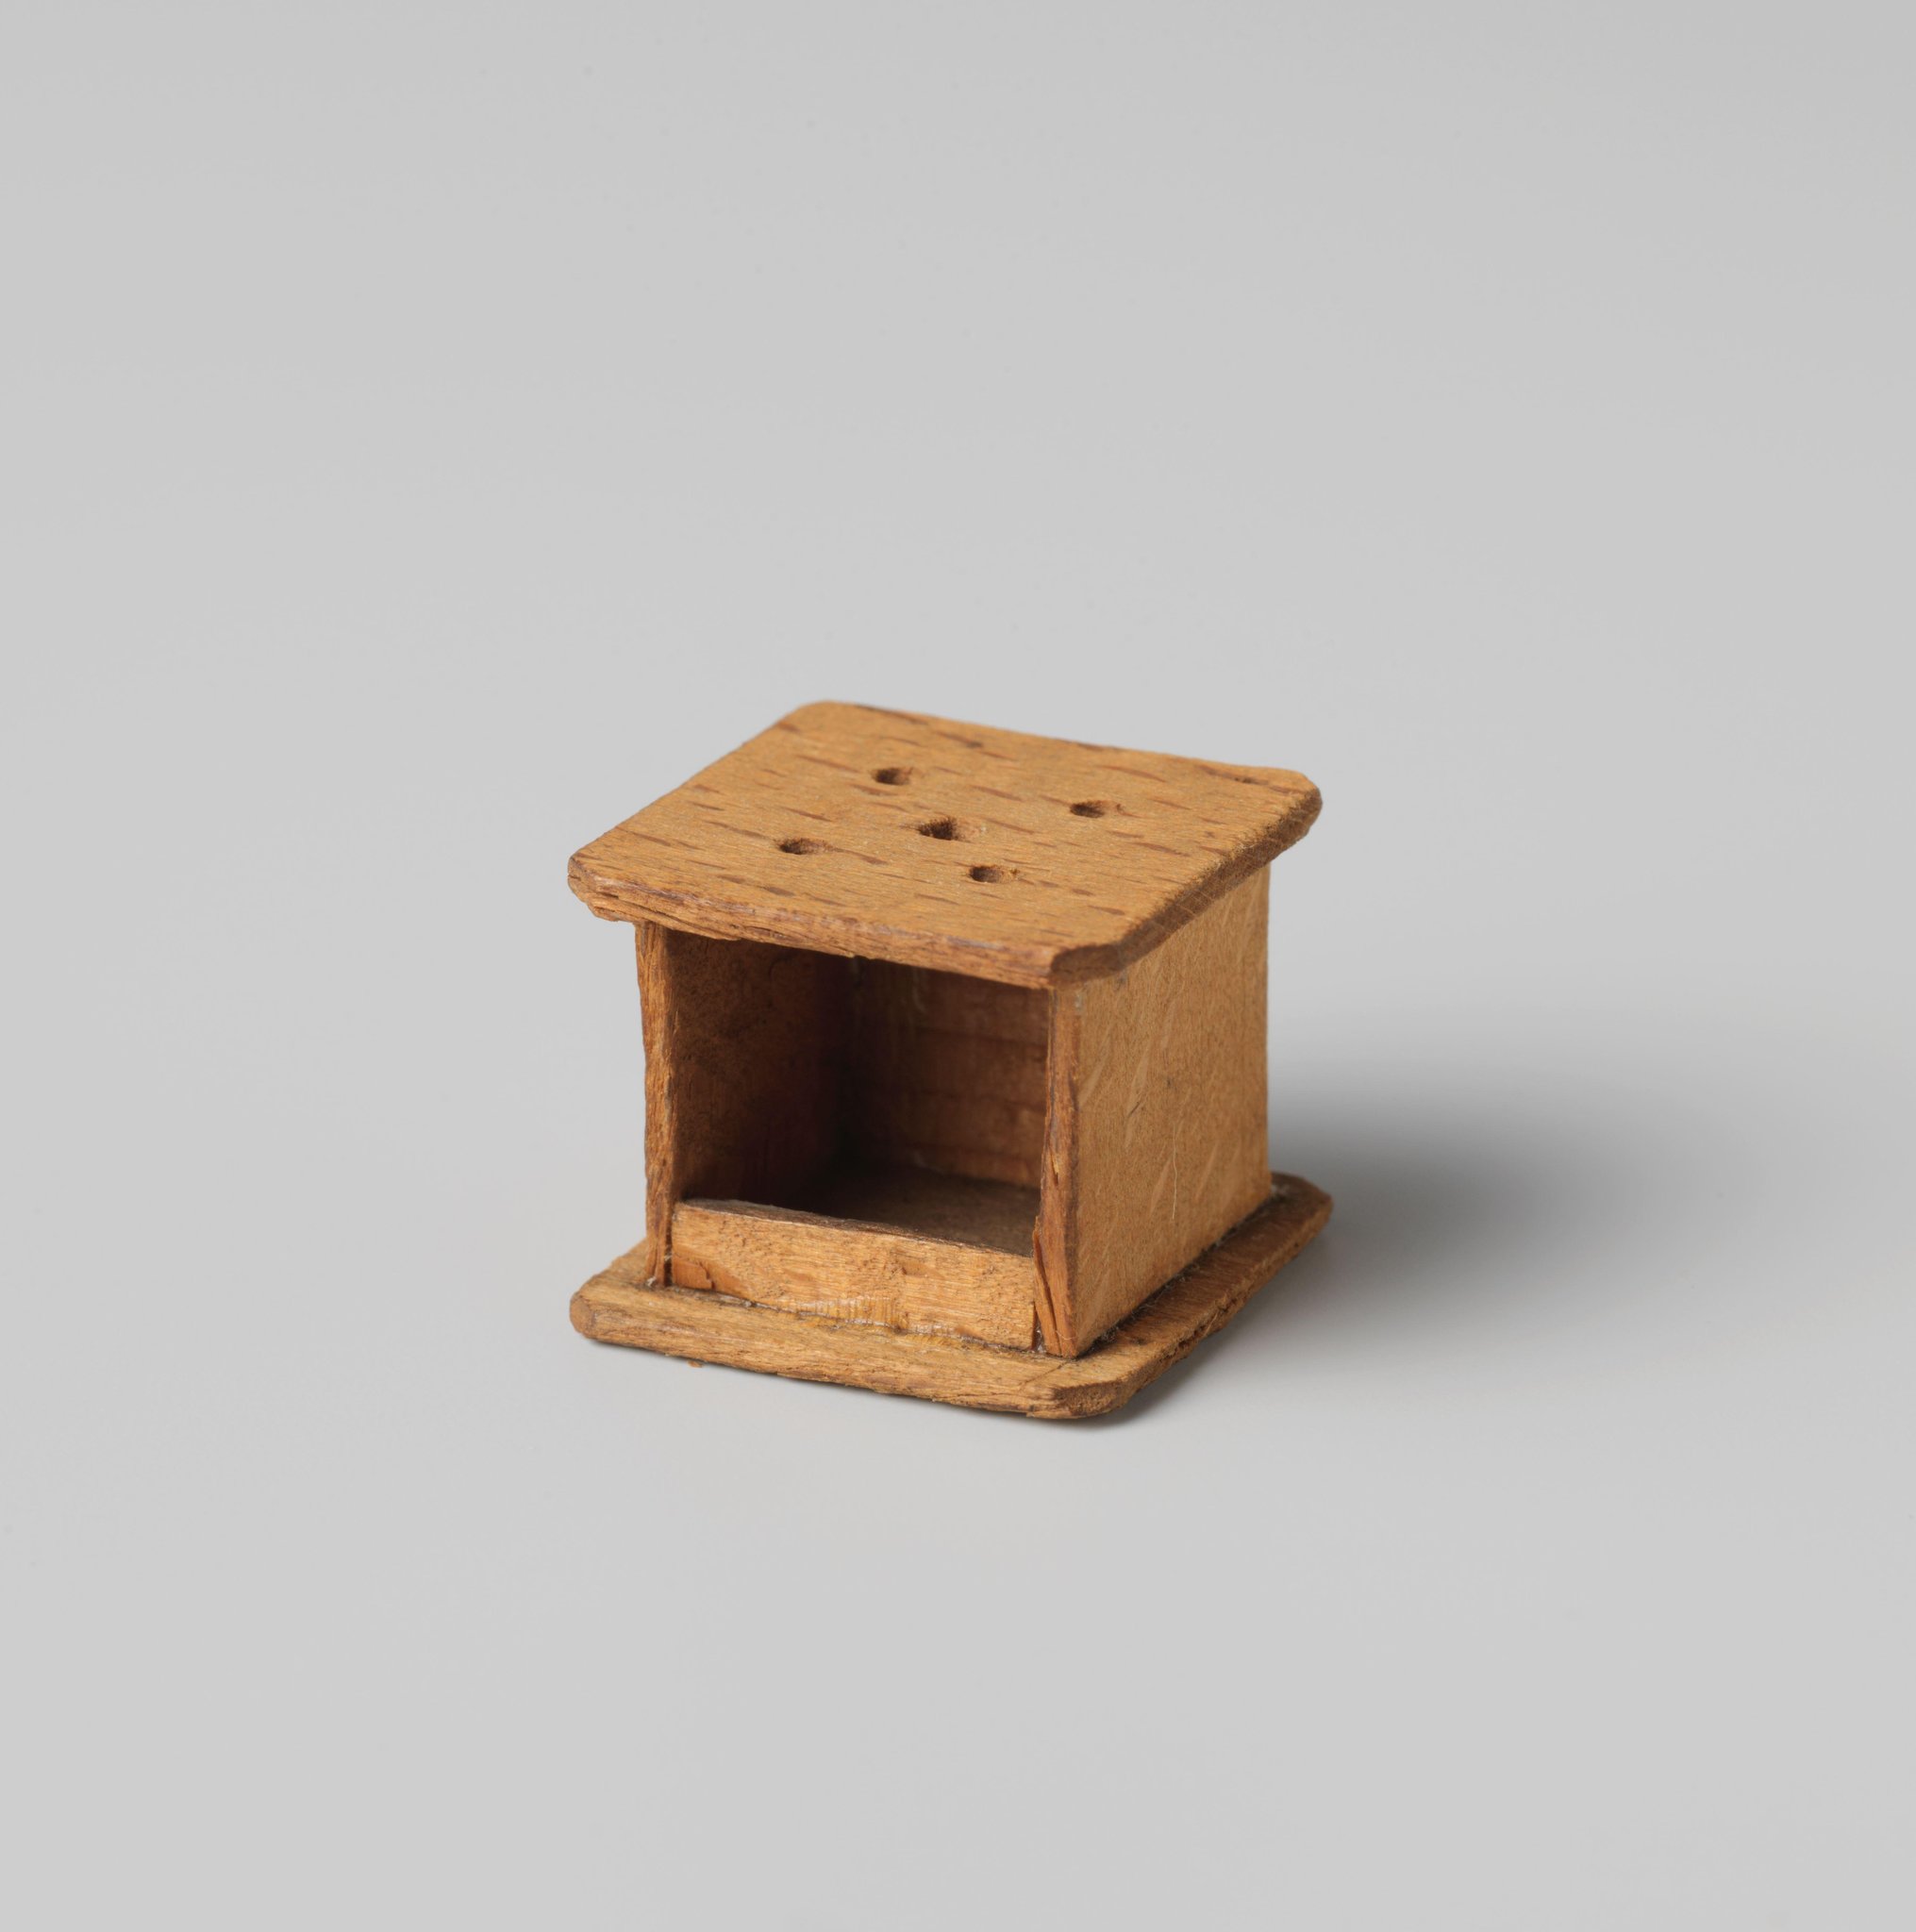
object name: voetstoof, stoof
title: Stoof, rechthoekig, met vijf gaten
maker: Anonymous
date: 1750-1800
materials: wood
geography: amsterdam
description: Stoof van beukenhout, rechthoekig, met vijf gaten in de bovenzijde; de achterzijde van grenenhout.